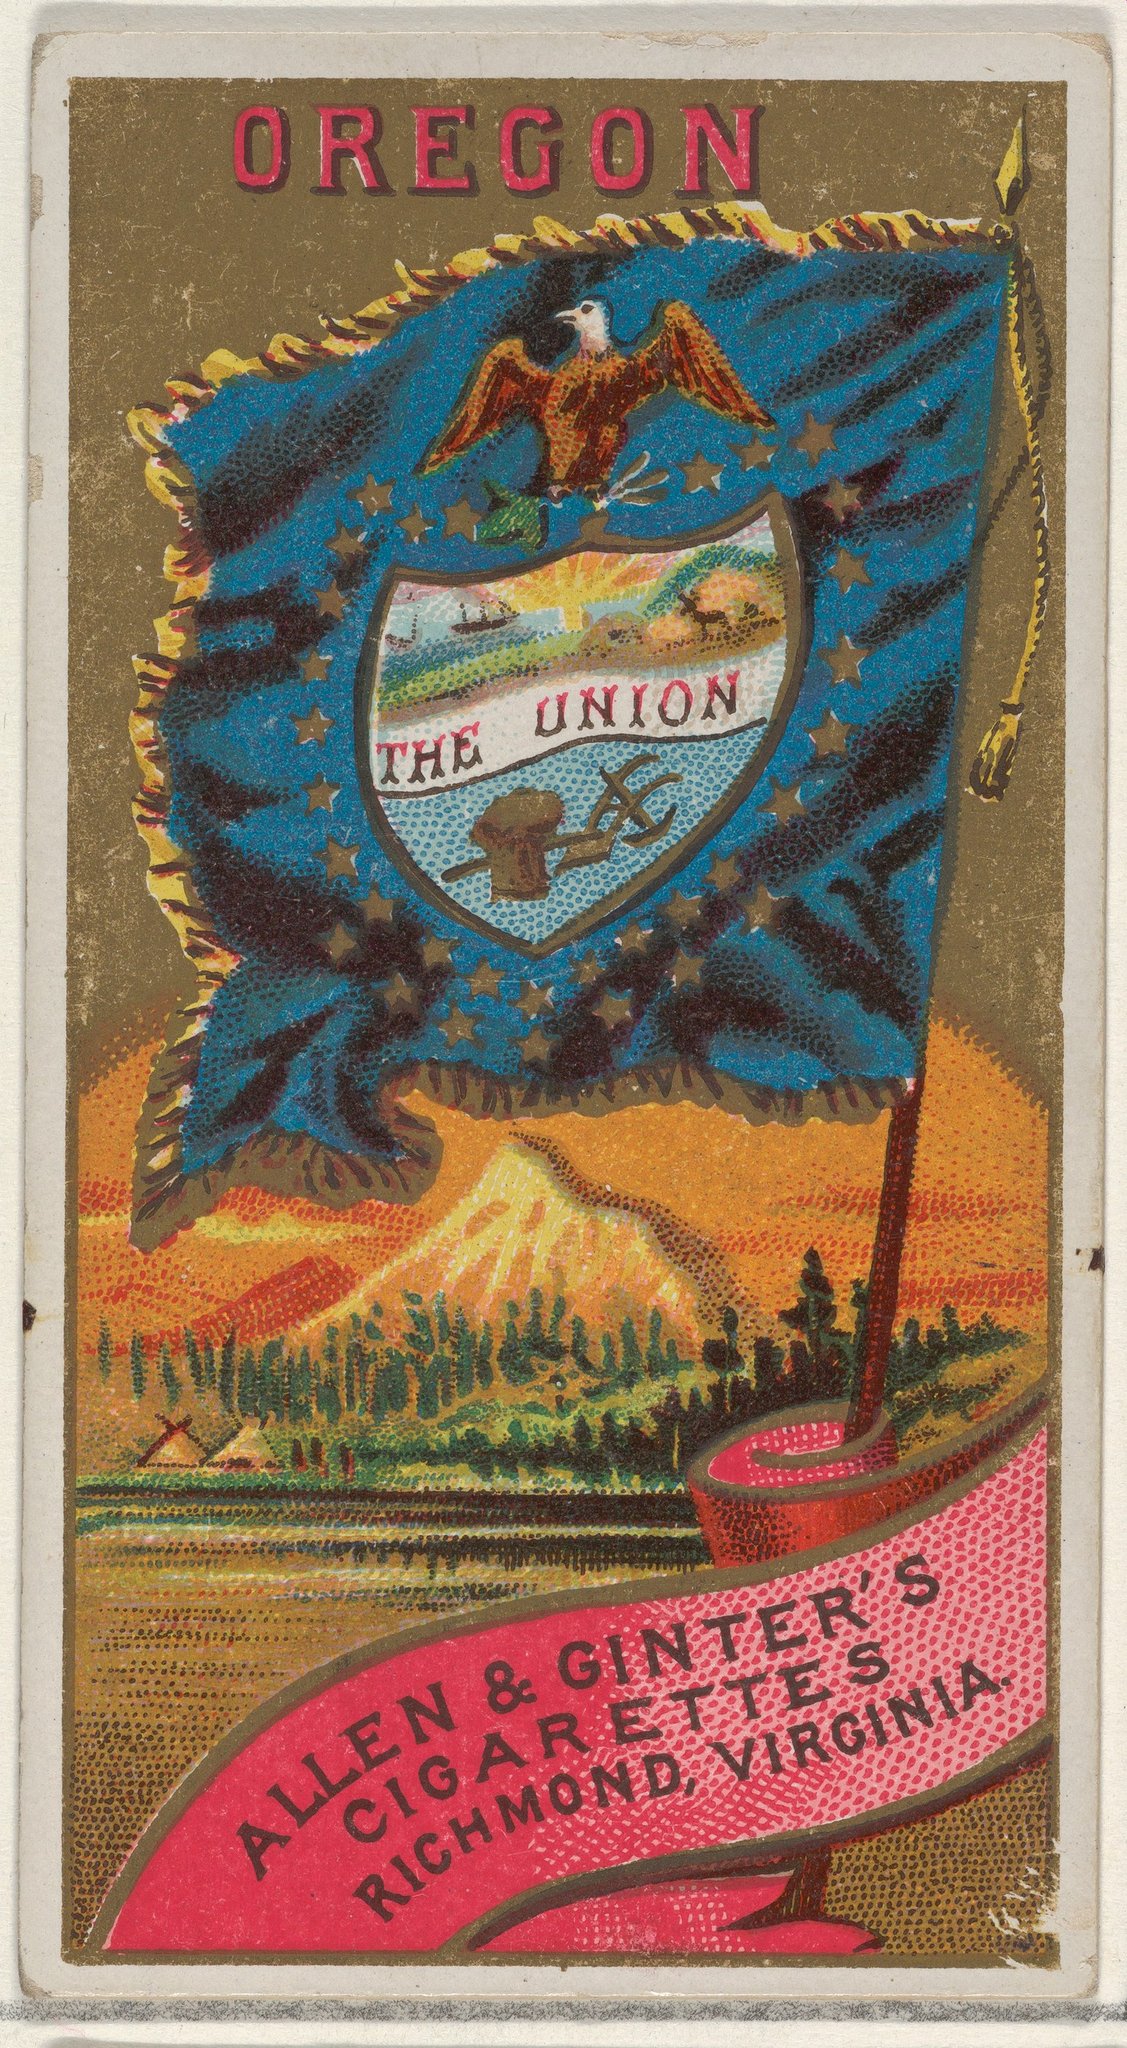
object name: print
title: Oregon, from Flags of the States and Territories (N11) for Allen & Ginter Cigarettes Brands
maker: allen & ginter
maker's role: publisher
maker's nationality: american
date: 1888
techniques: color lithograph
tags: flags